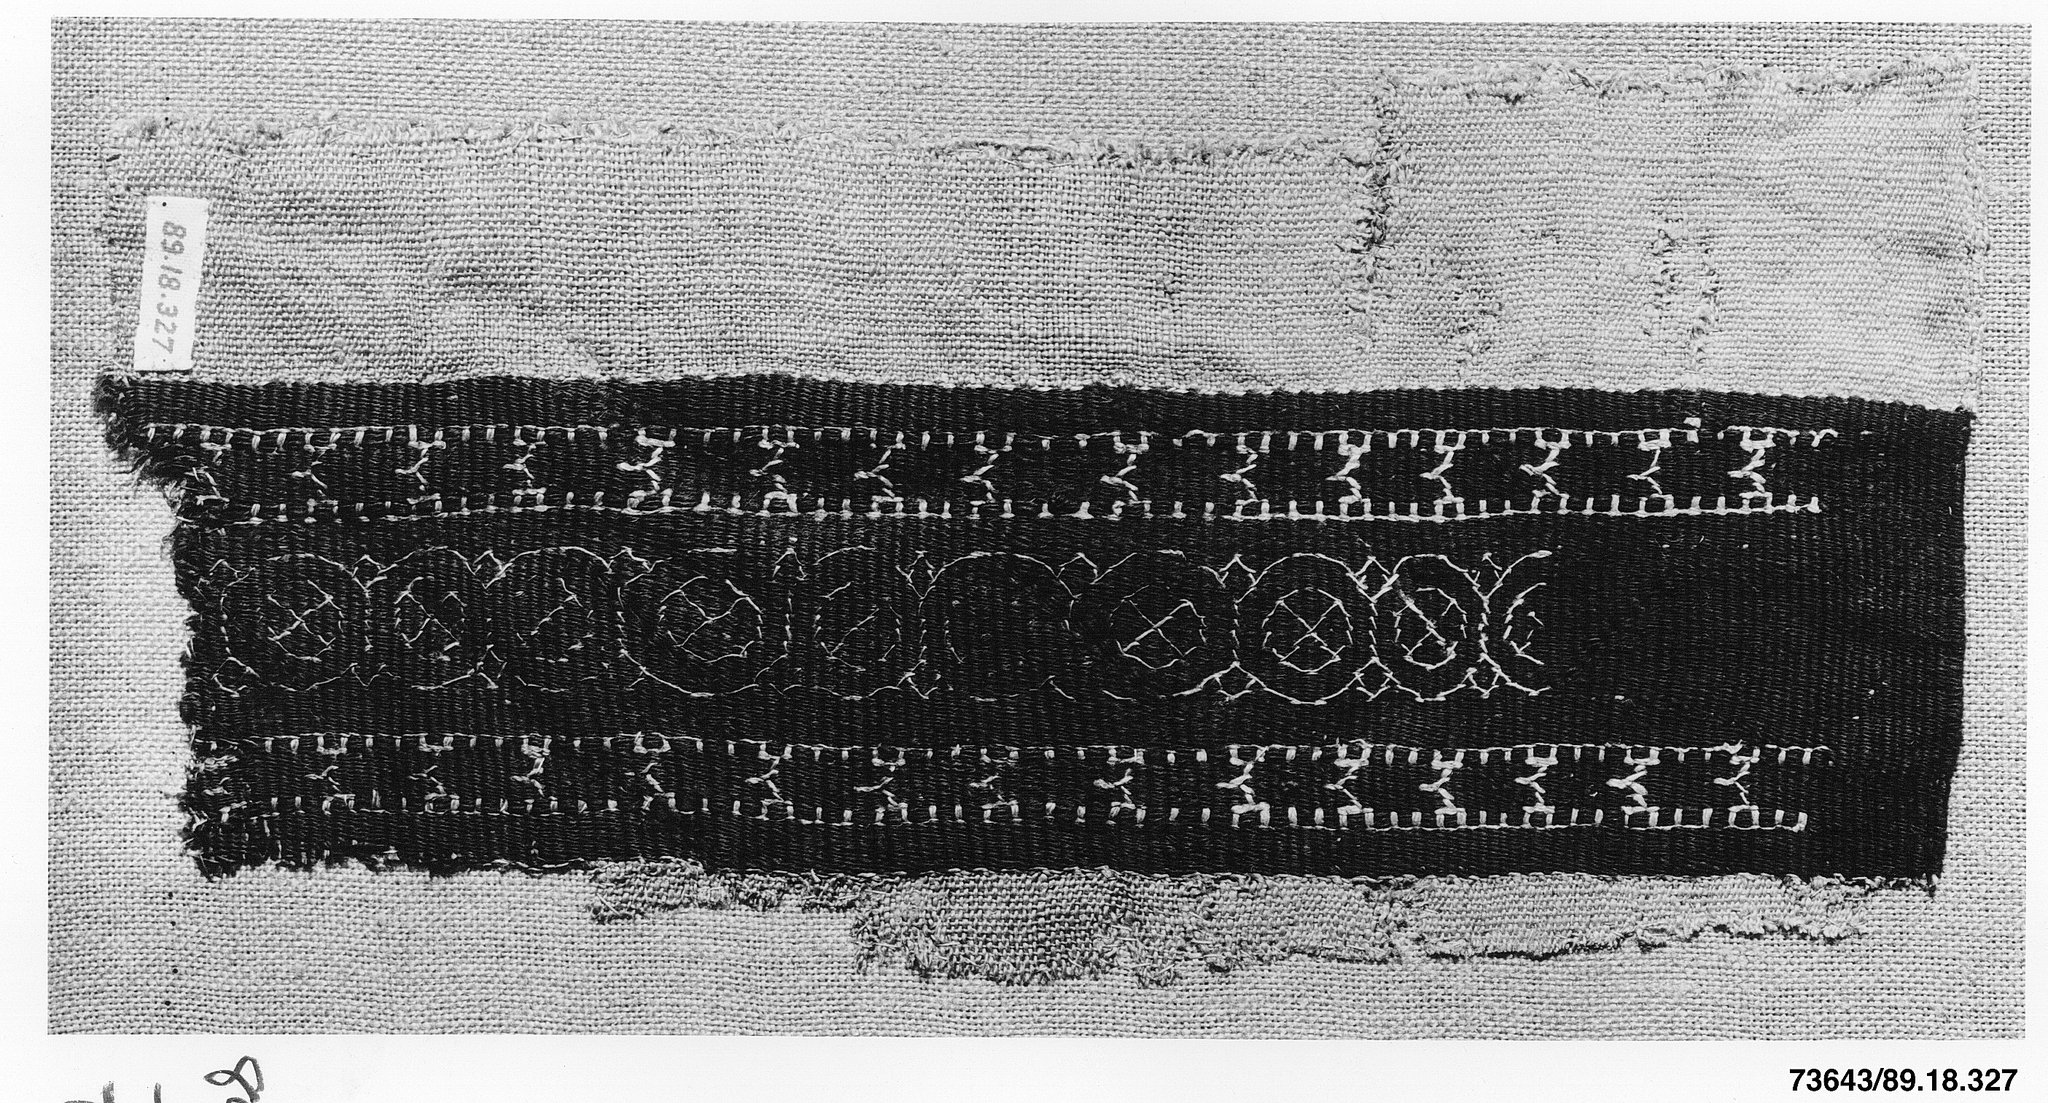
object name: textile fragment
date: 201-400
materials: linen, wool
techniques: weave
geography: egypt